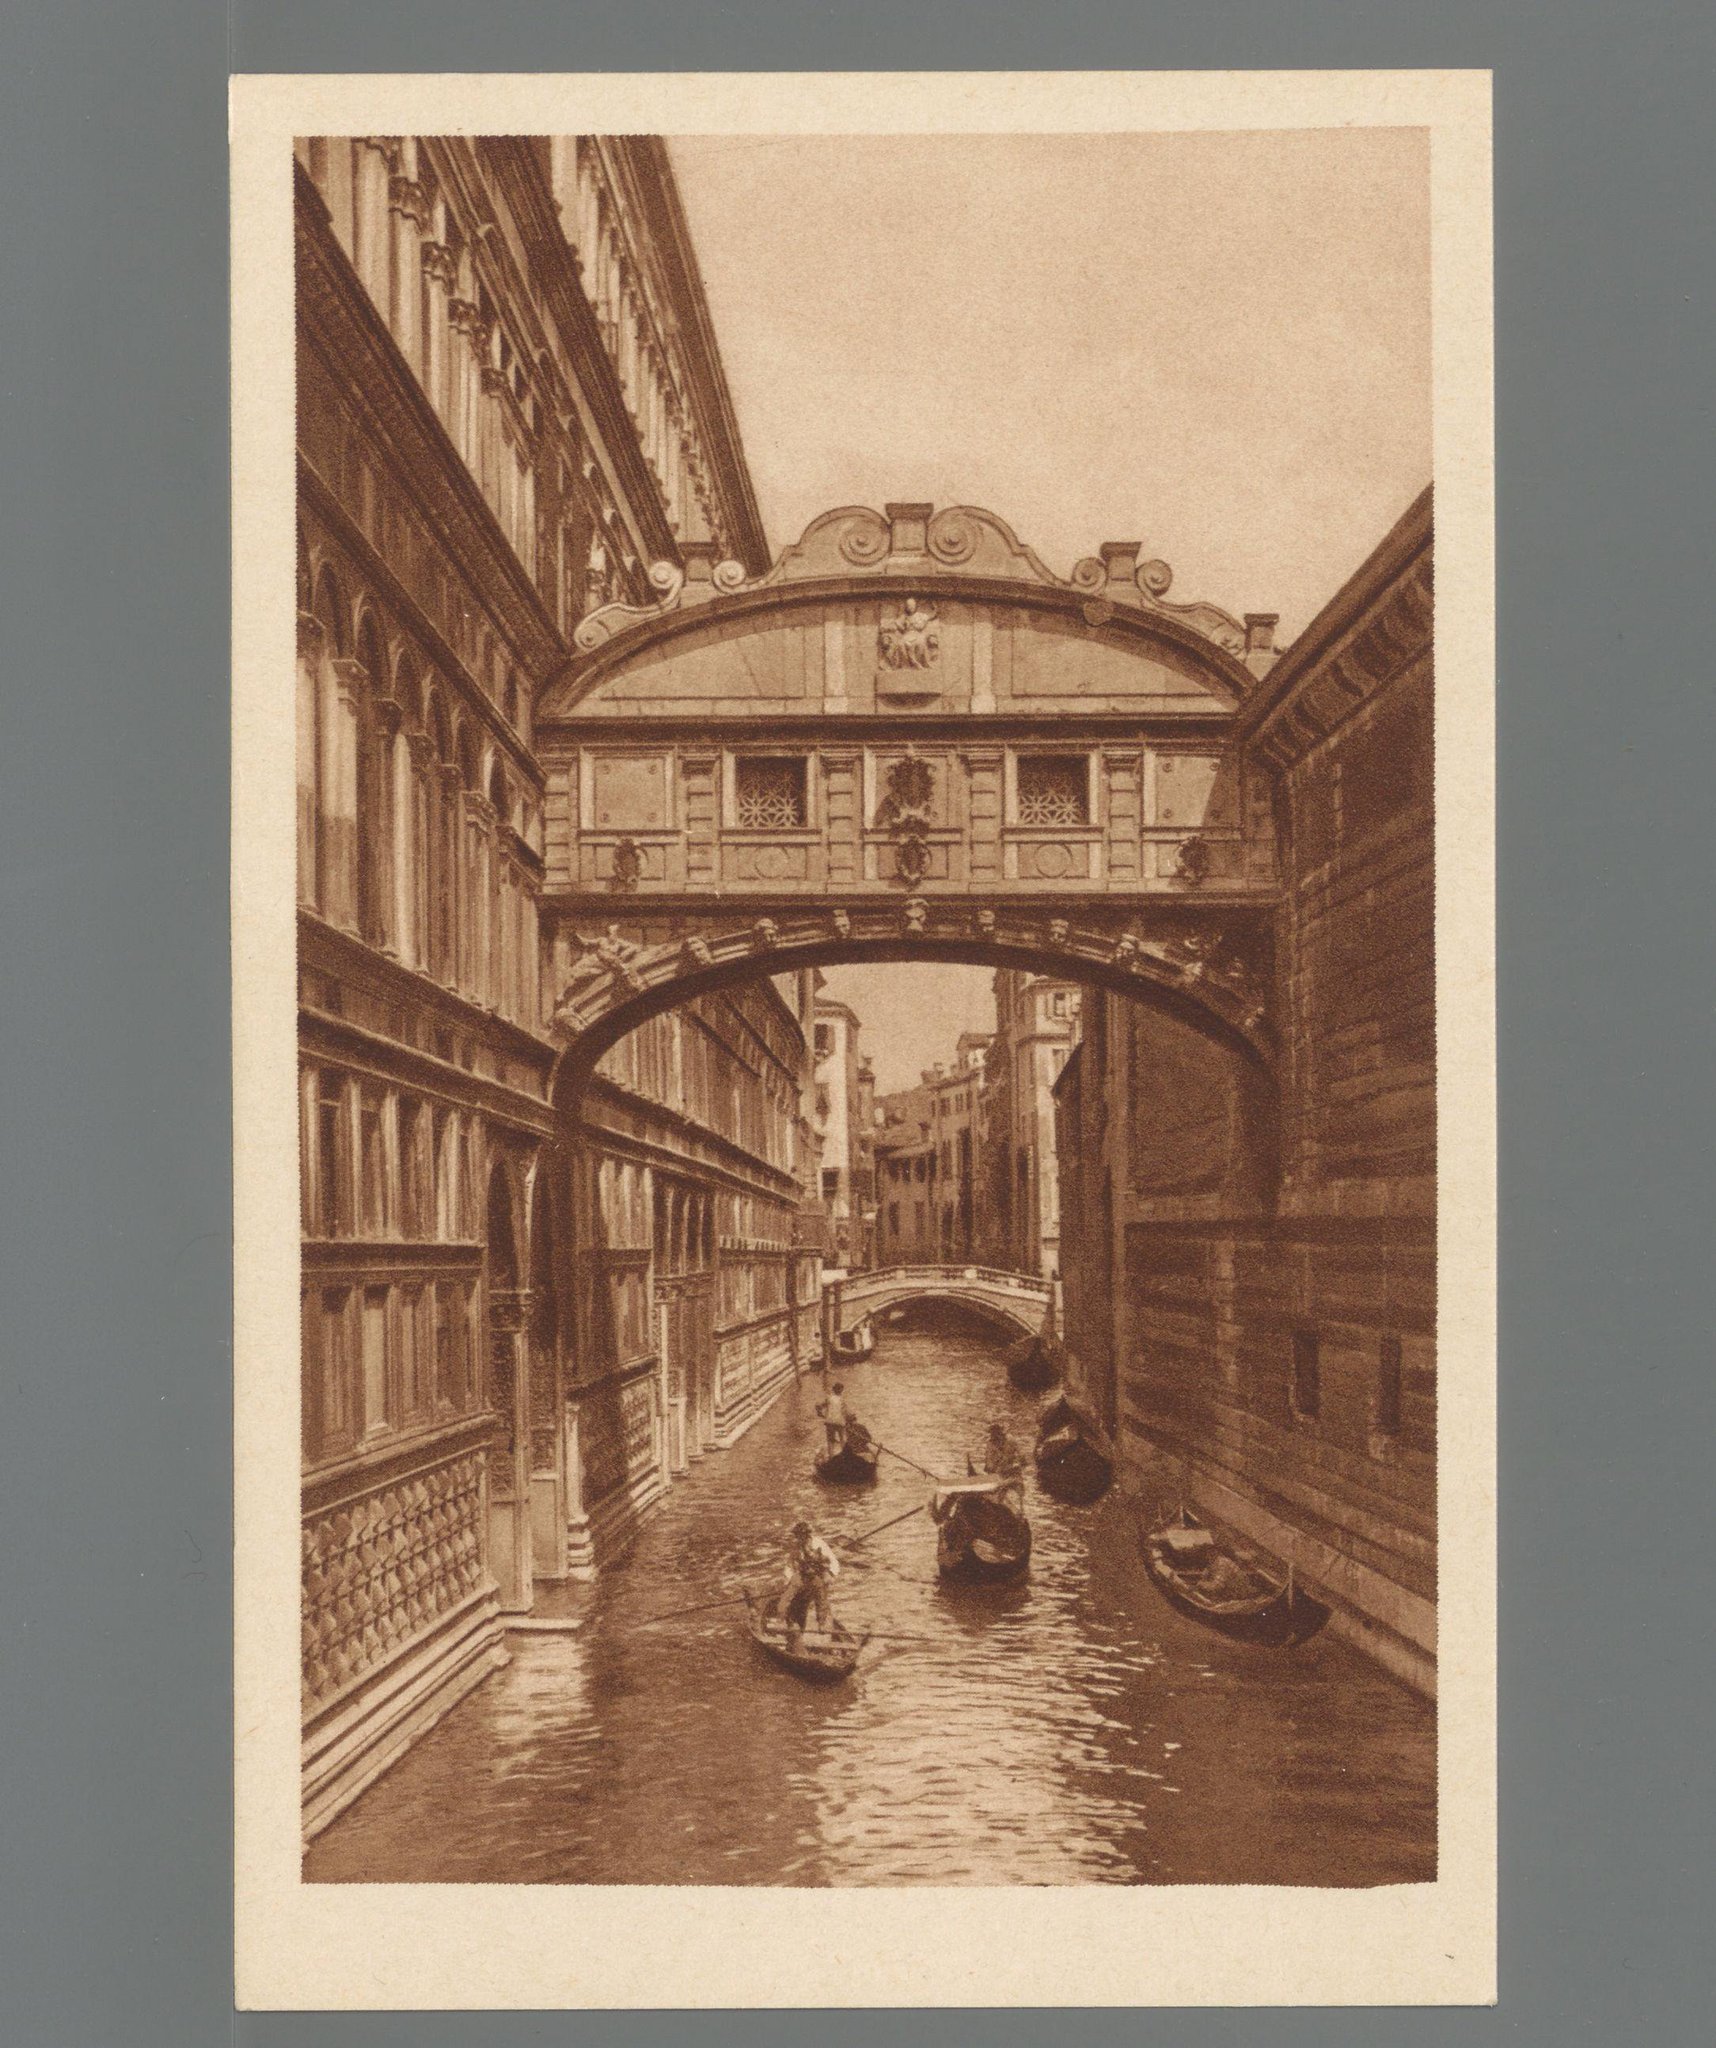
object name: ansichtkaart, prentbriefkaart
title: Venezia. Ponte dei Sospiri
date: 1906-1930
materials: cardboard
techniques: rotogravure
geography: venice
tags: bridge in city across river, canal, etc. (+ city(-scape) with figures, staffage), gondola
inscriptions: collector's mark: ‘AFE v S’